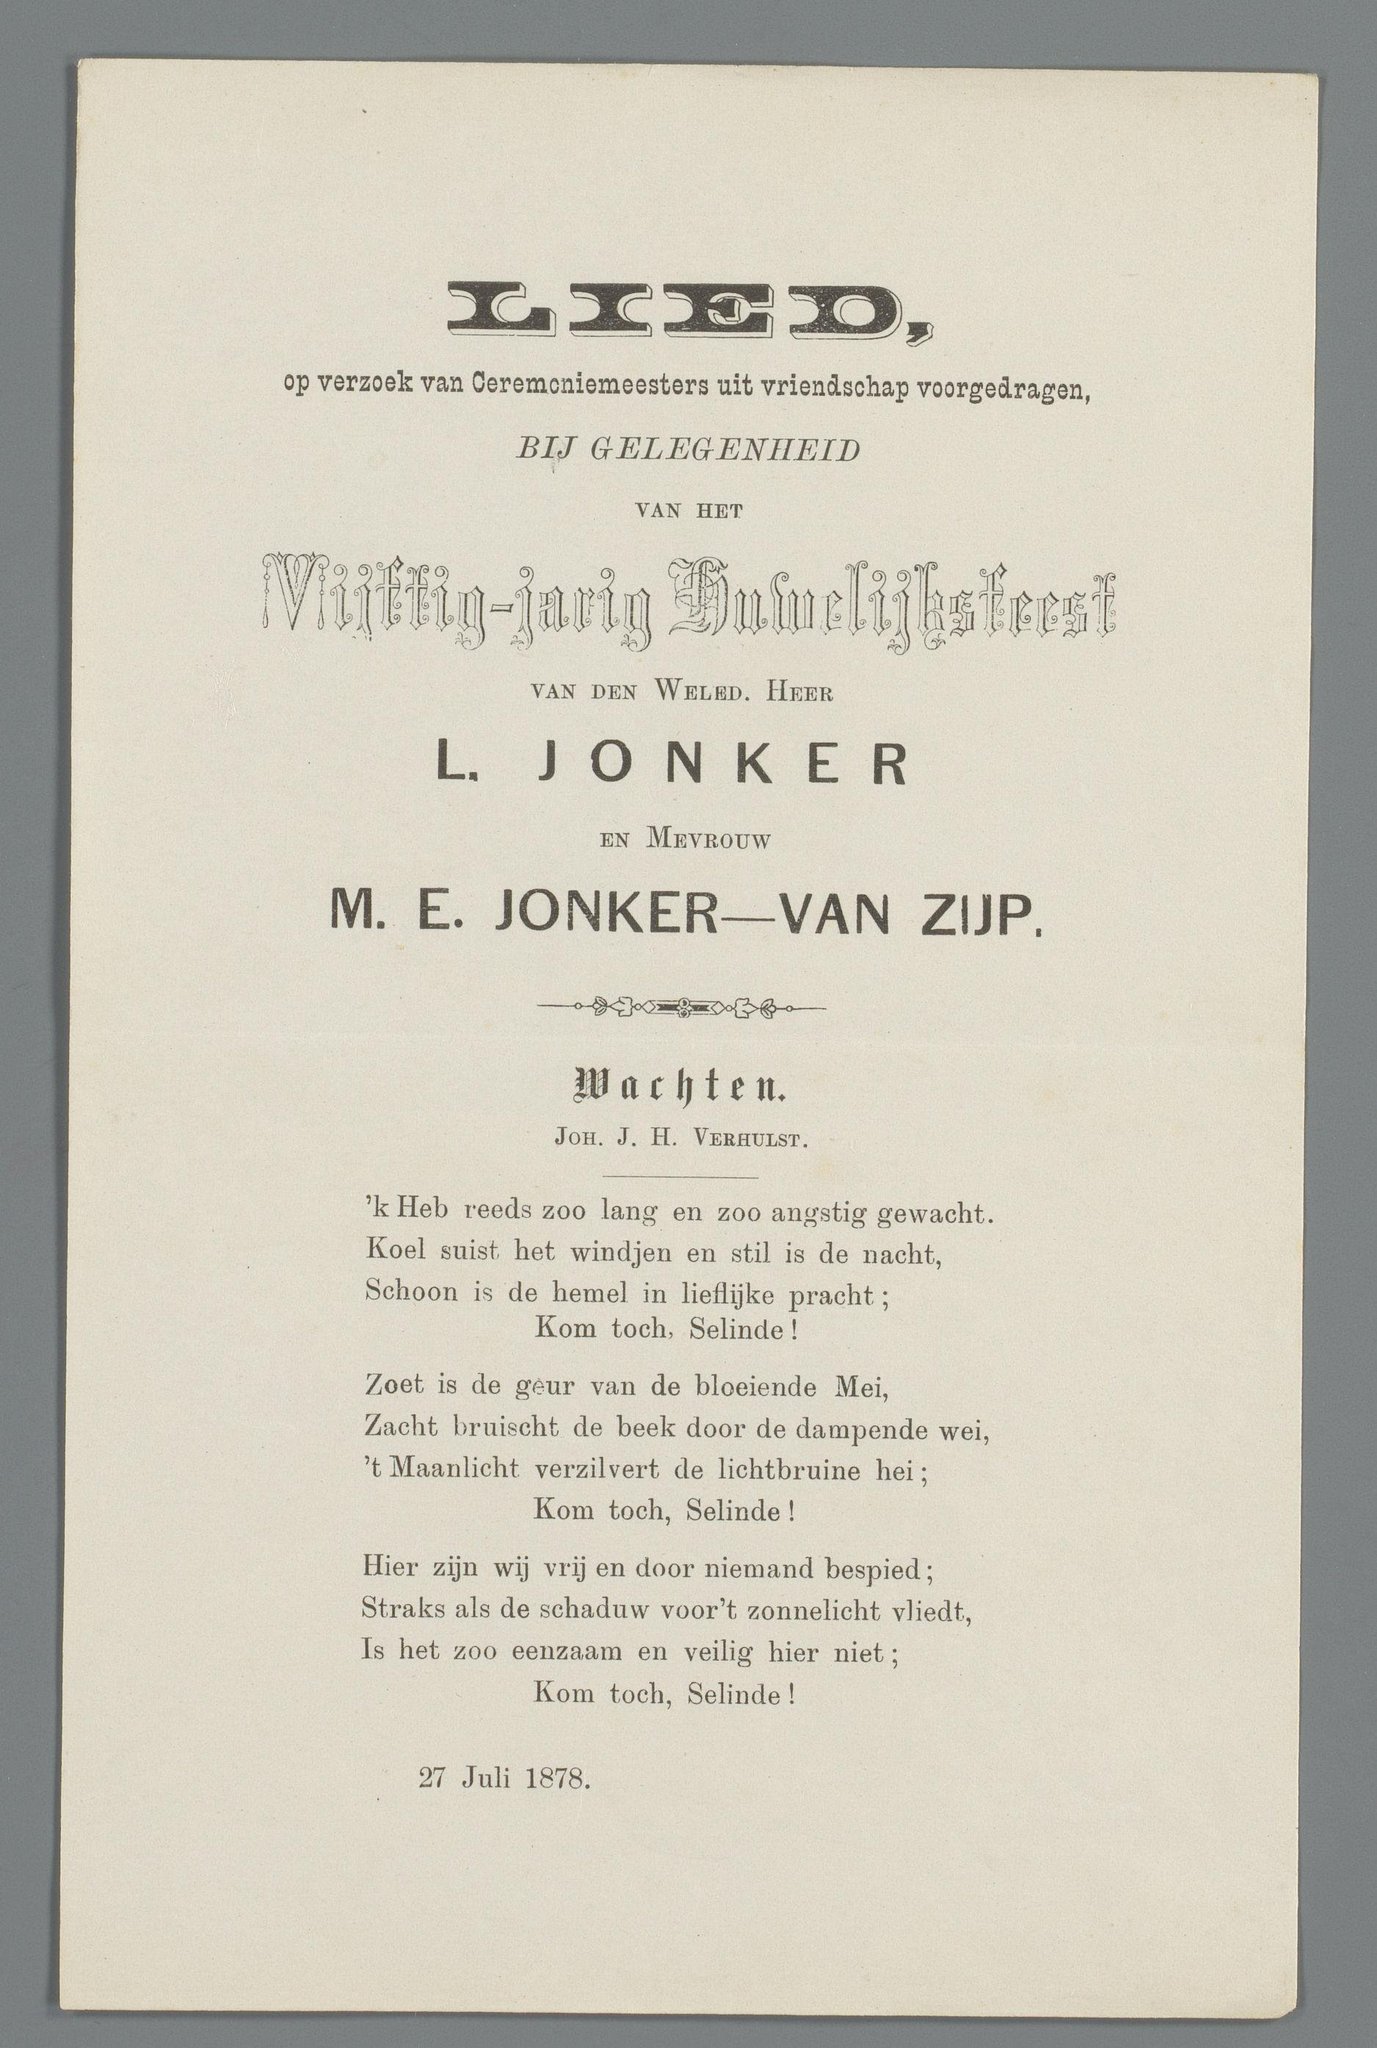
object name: text sheet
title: Wachten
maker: johannes verhulst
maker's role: componist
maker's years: 1816-1891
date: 1878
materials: paper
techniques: letterpress printing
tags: marriage, married couple, 'matrimonium'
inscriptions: collector's mark: Lugt 2228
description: Eenzijdig bedrukt tekstblad met een liedtekst.